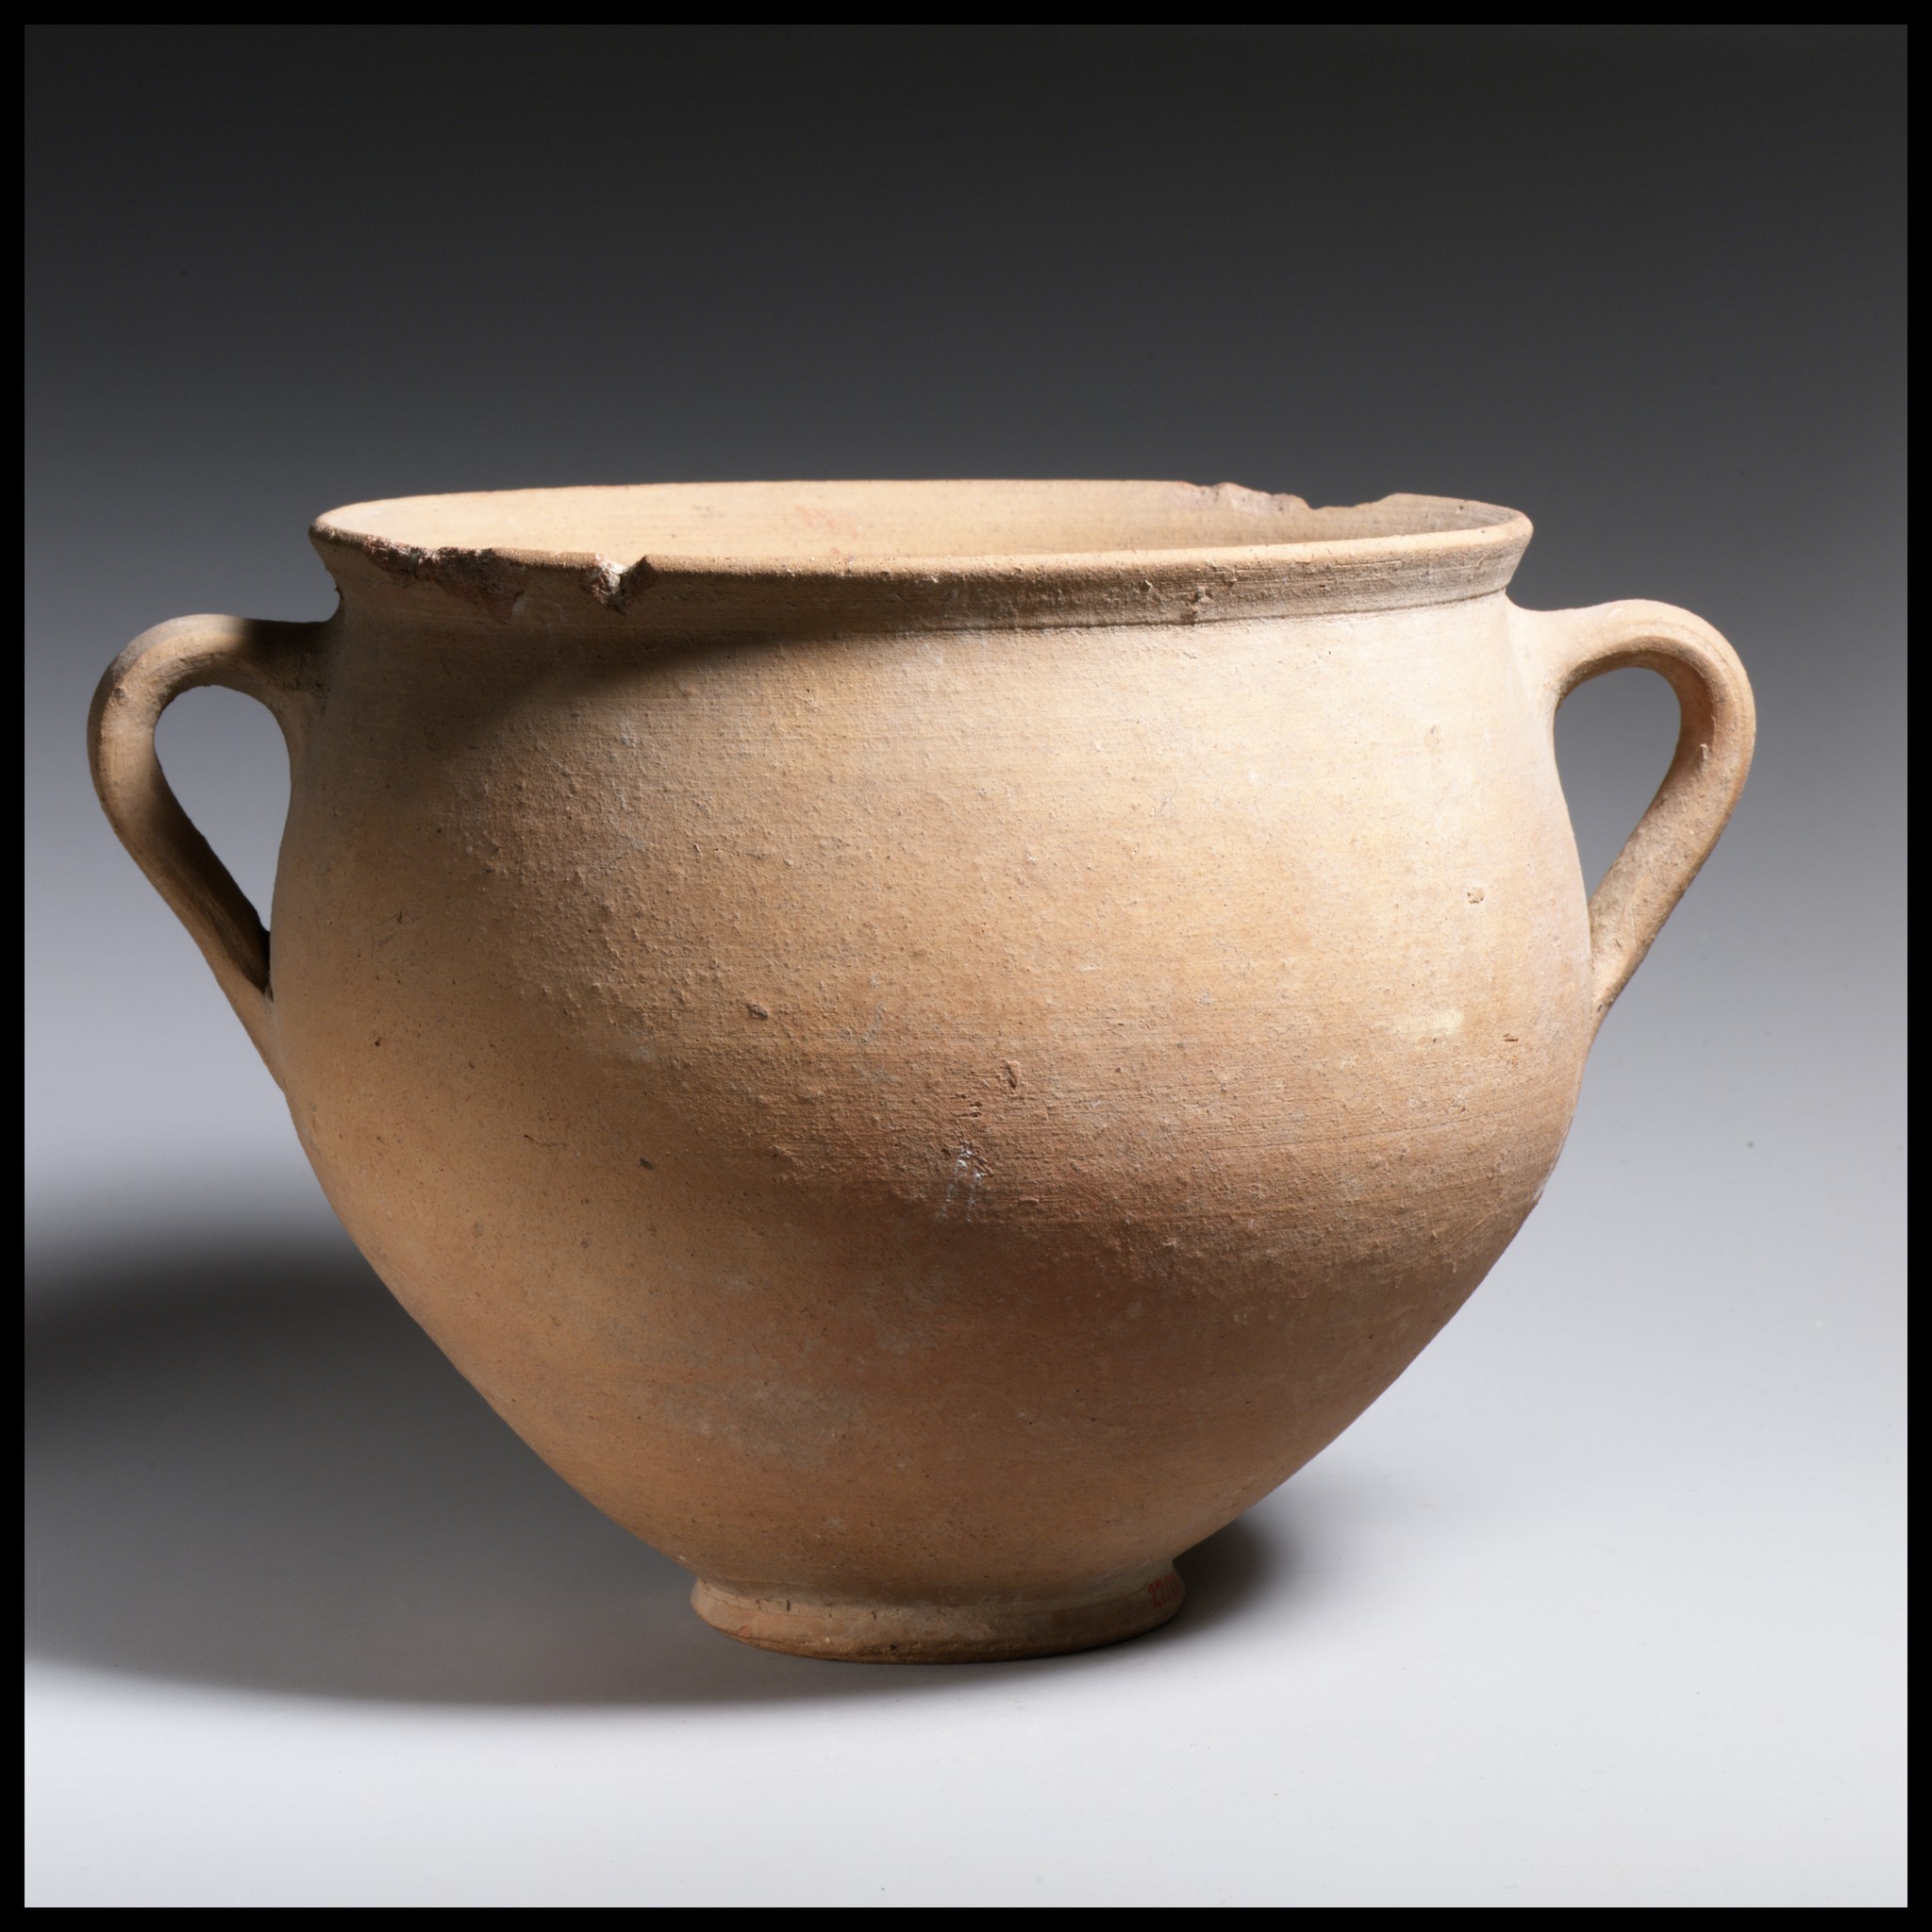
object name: jar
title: Terracotta deep bowl with two vertical handles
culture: mycenaean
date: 1400-1190 BCE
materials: terracotta